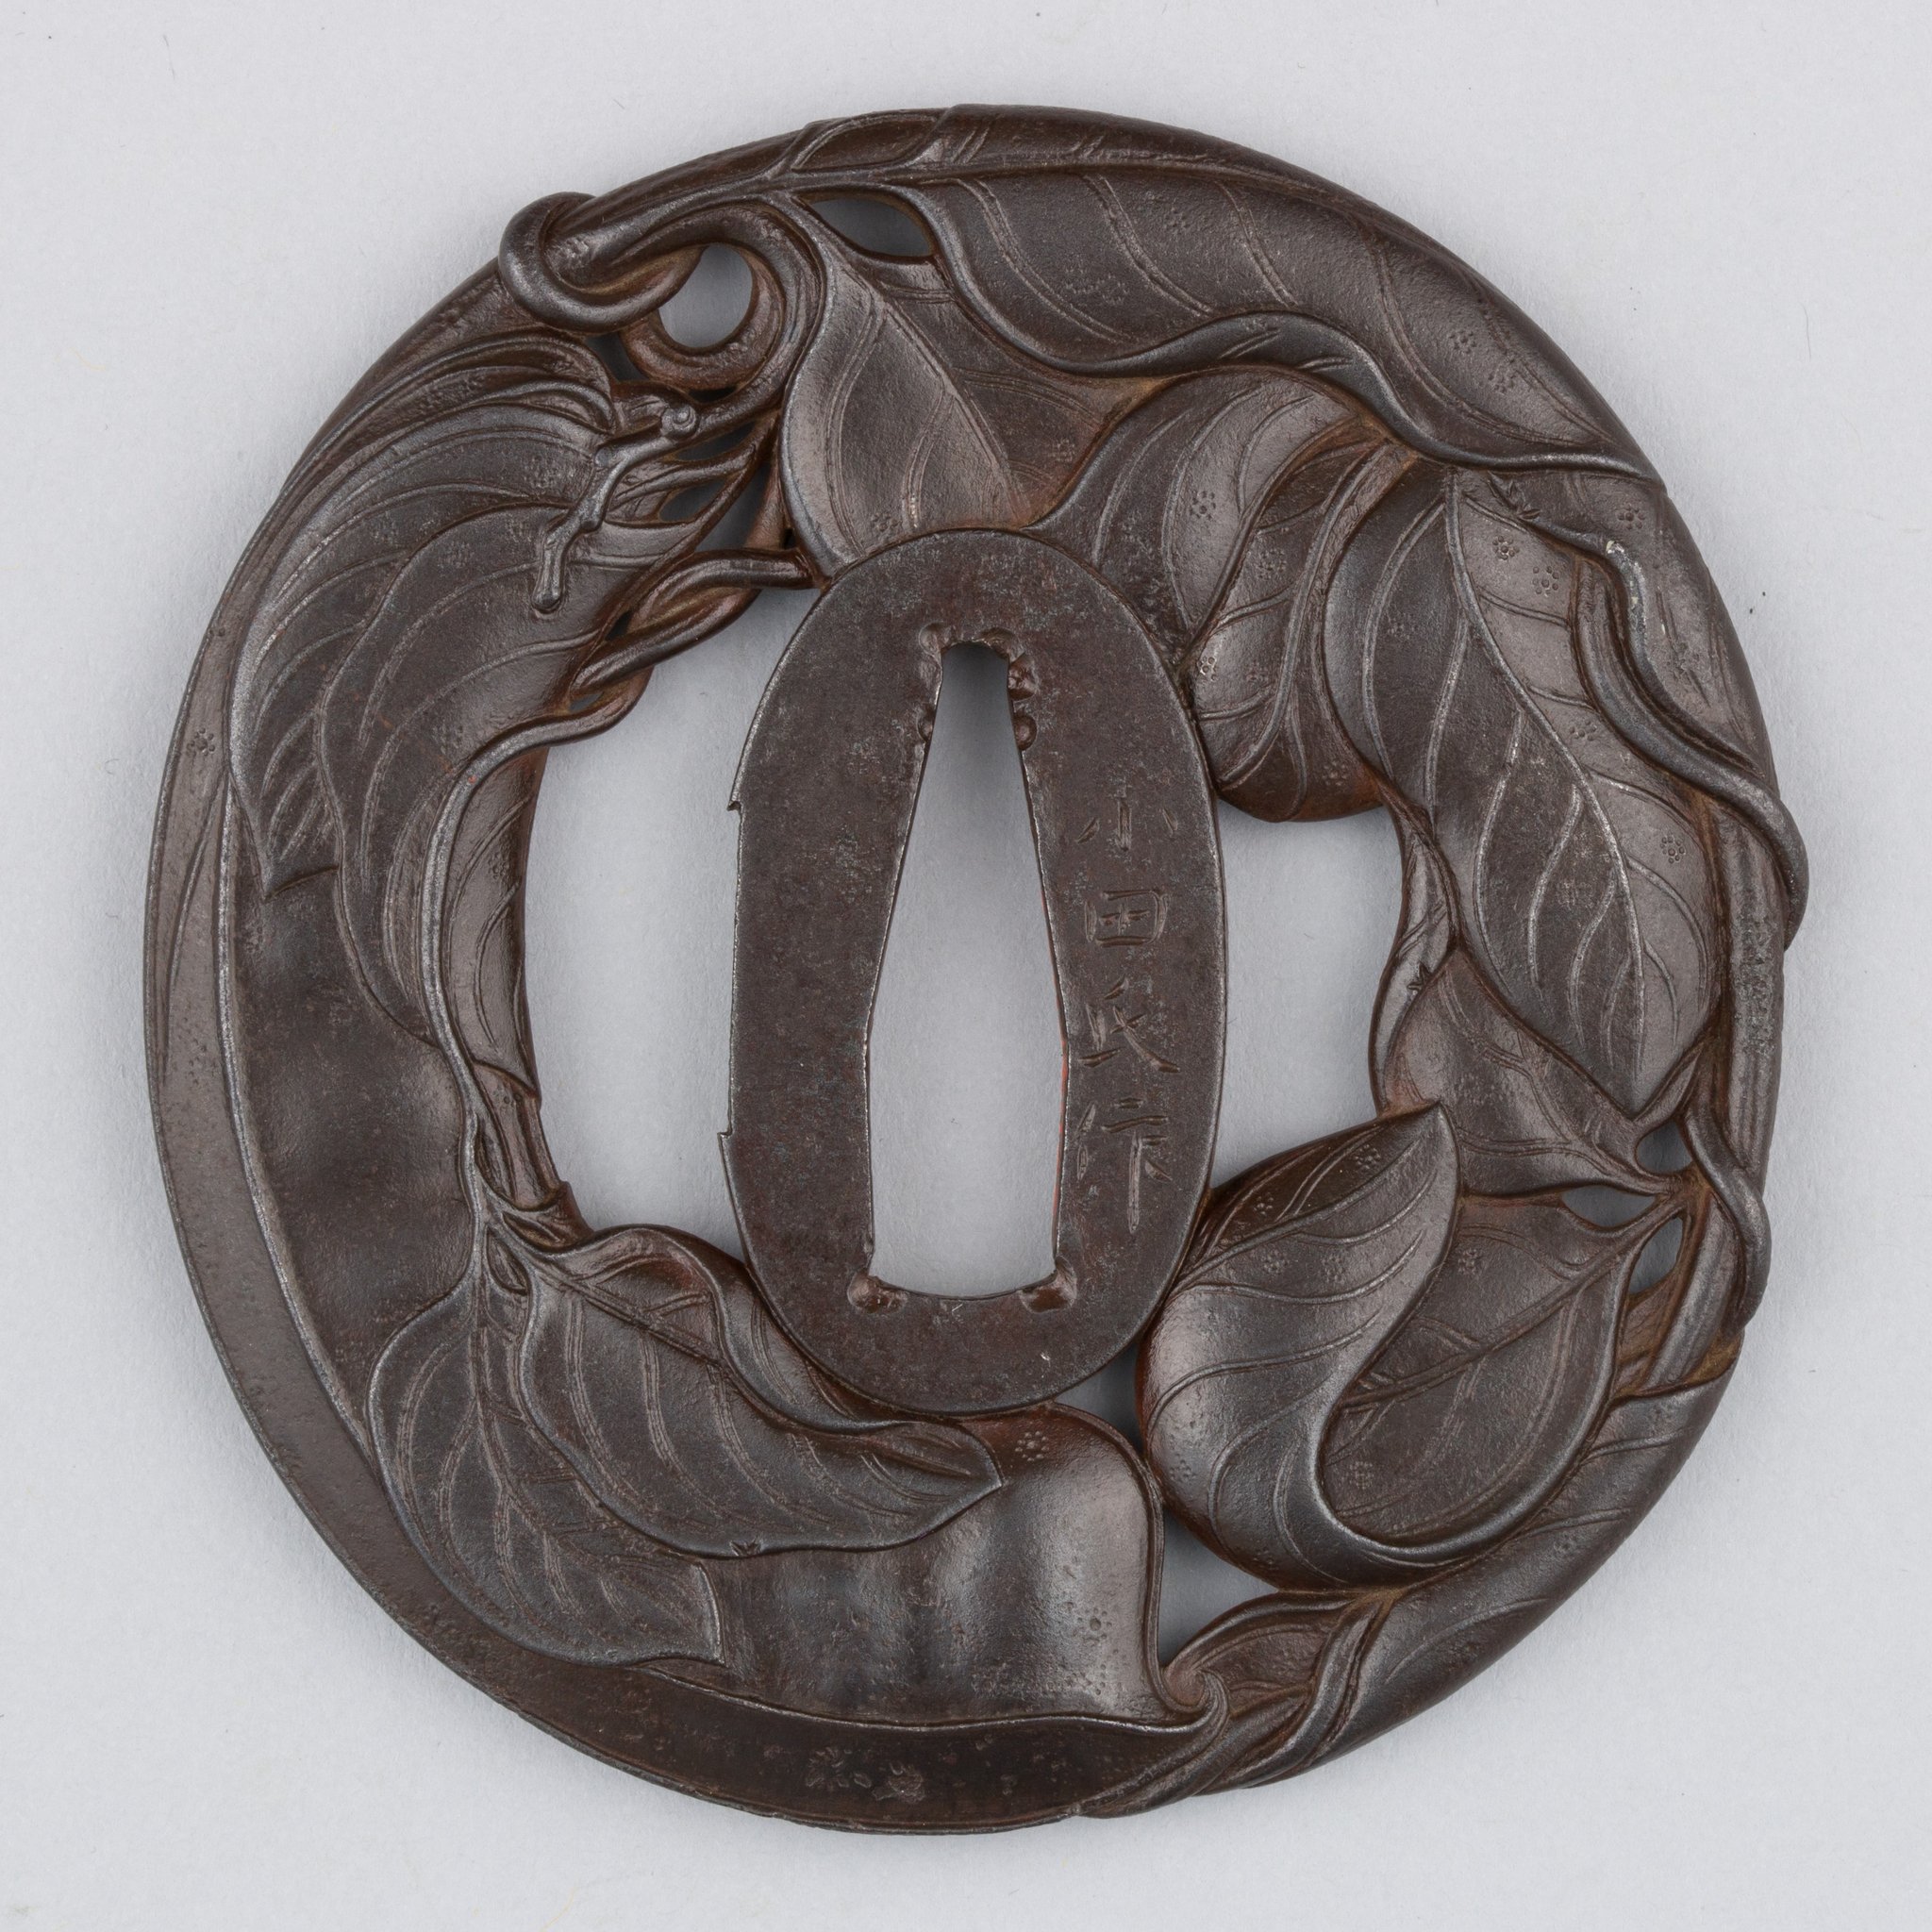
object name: sword guard tsuba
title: Sword Guard (Tsuba)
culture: japanese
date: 1701-1800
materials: copper, iron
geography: japan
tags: leaves